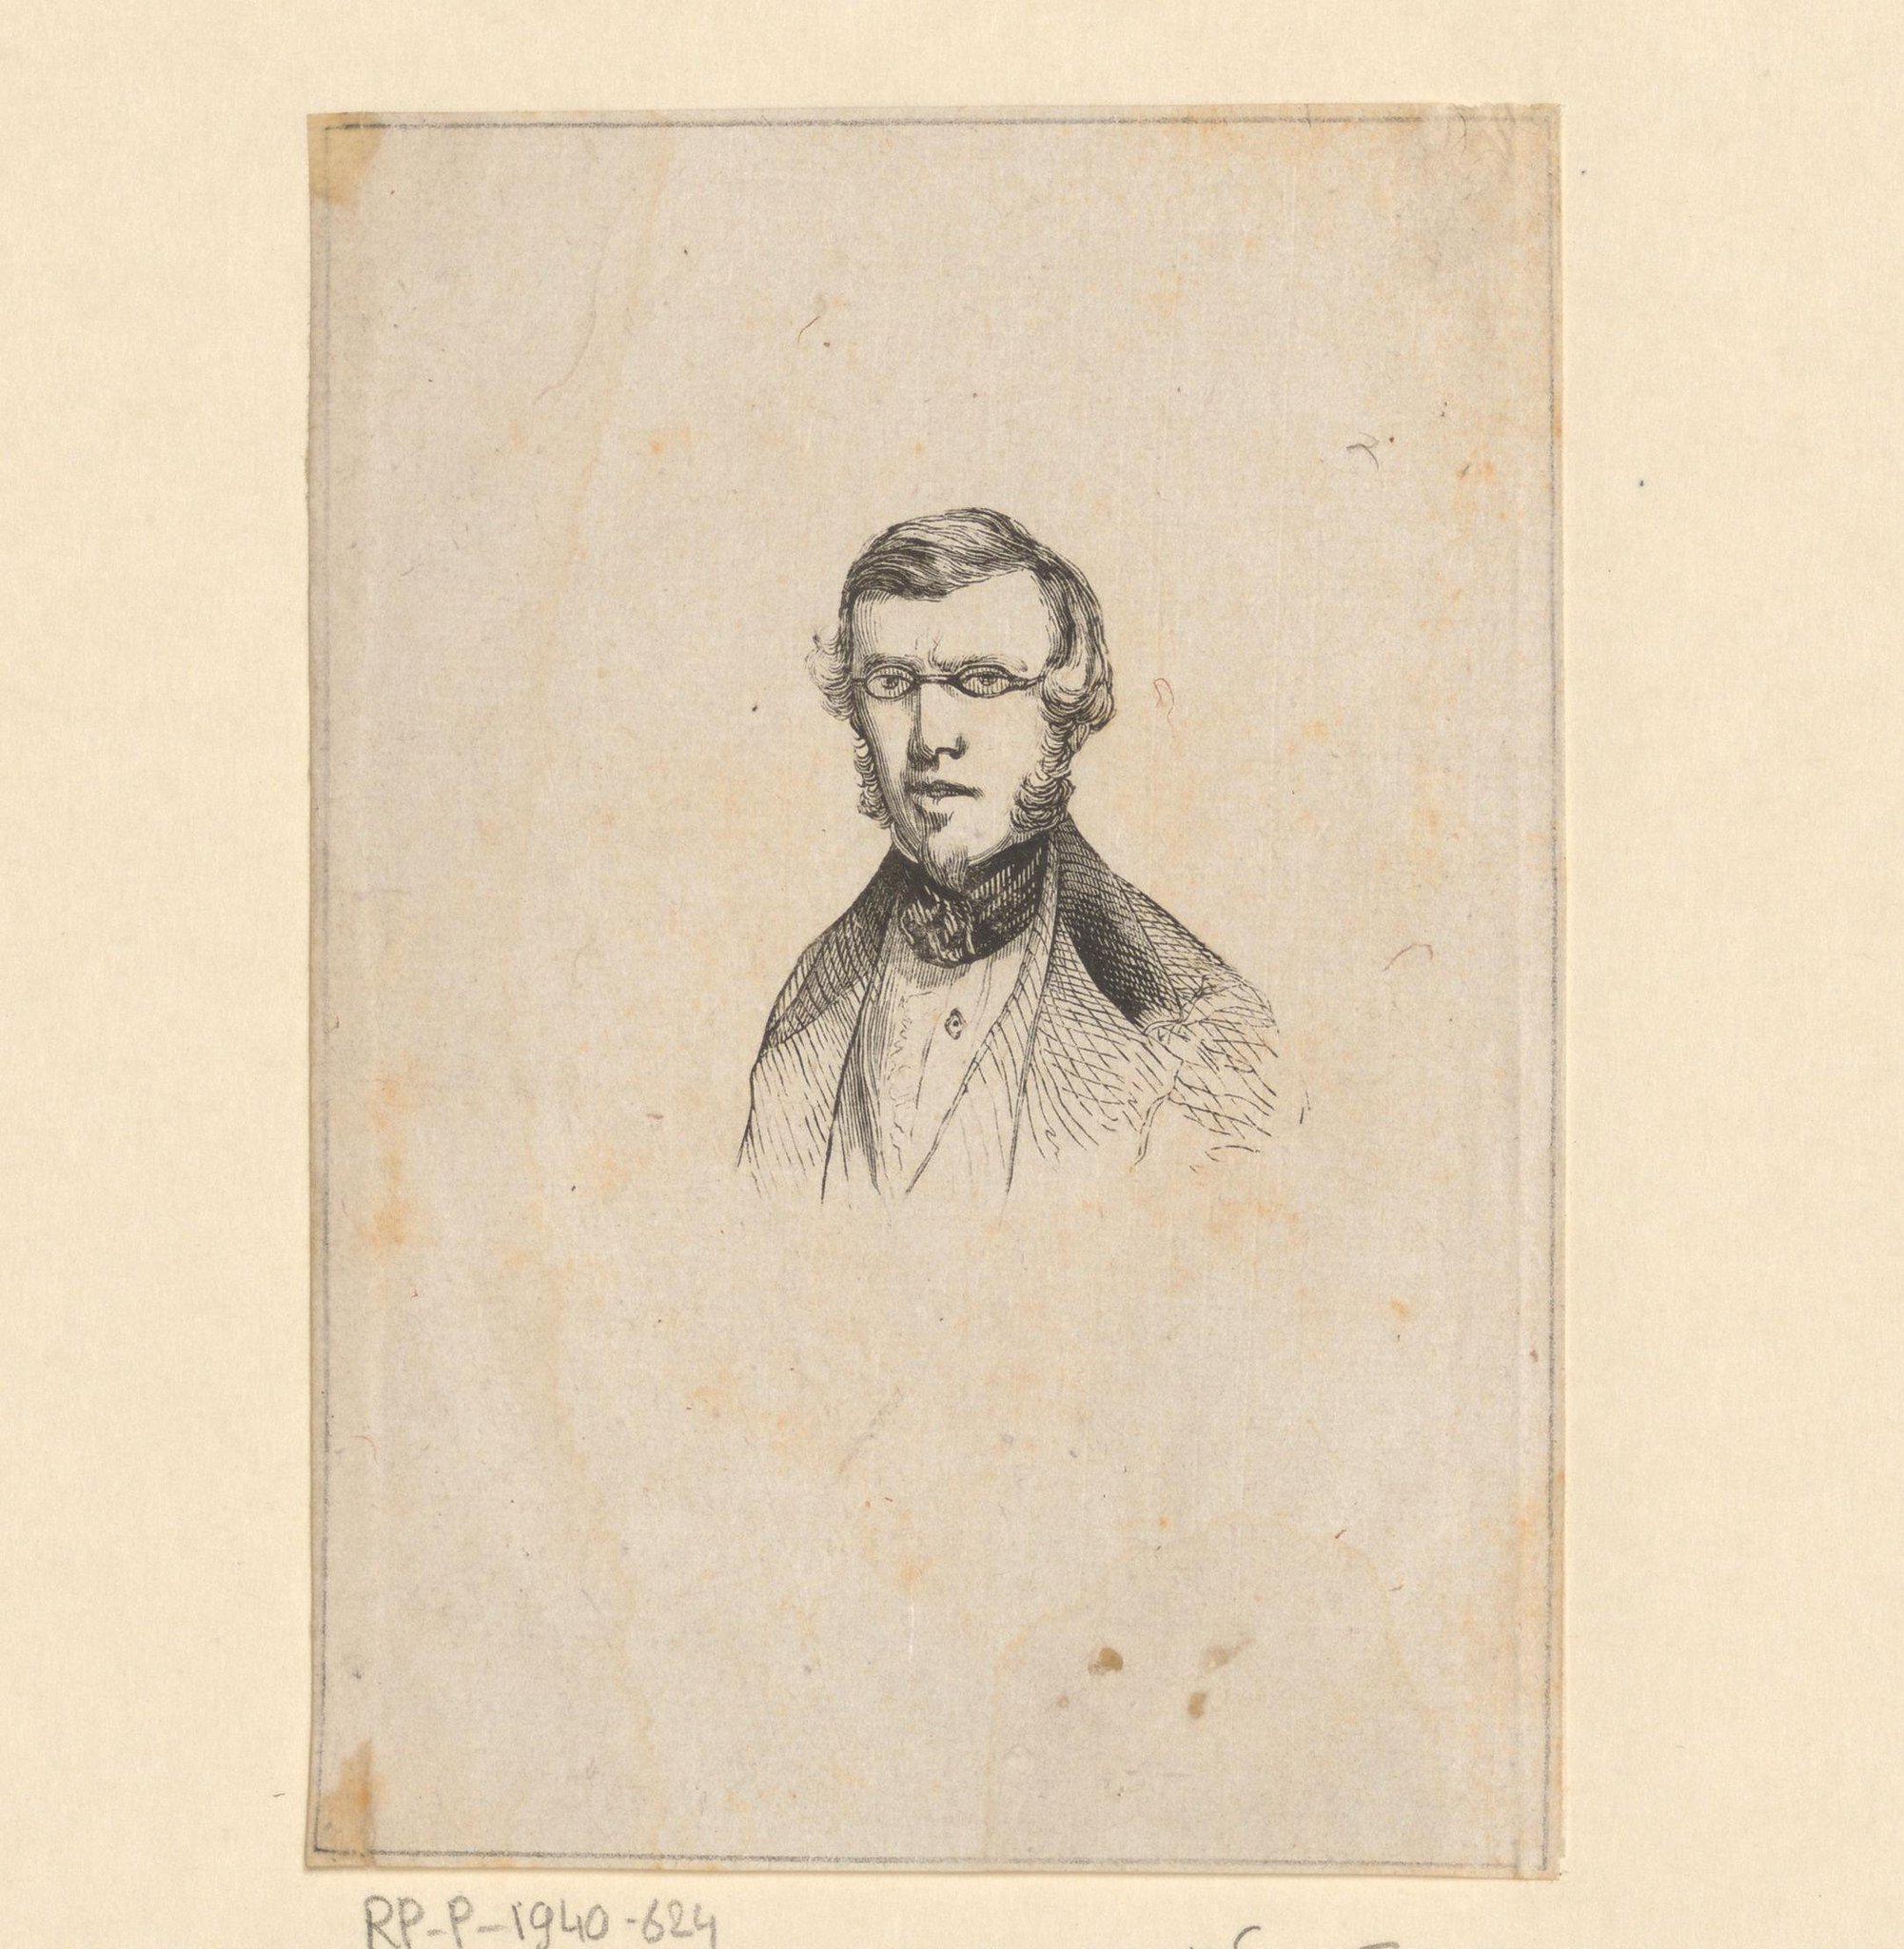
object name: print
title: Portret van Abraham Johannes Couwenberg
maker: Anonymous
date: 1842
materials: paper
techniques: engraving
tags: print maker, abraham johannes couwenberg, historical persons, portrait, self-portrait of painter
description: Prent mogelijk uit: Immerzeel, Johannes. De levens en werken der Hollandsche en Vlaamsche kunstschilders. Amsterdam: Johannes Christoffel van Kesteren, 1842, dl. 1, p. 151.